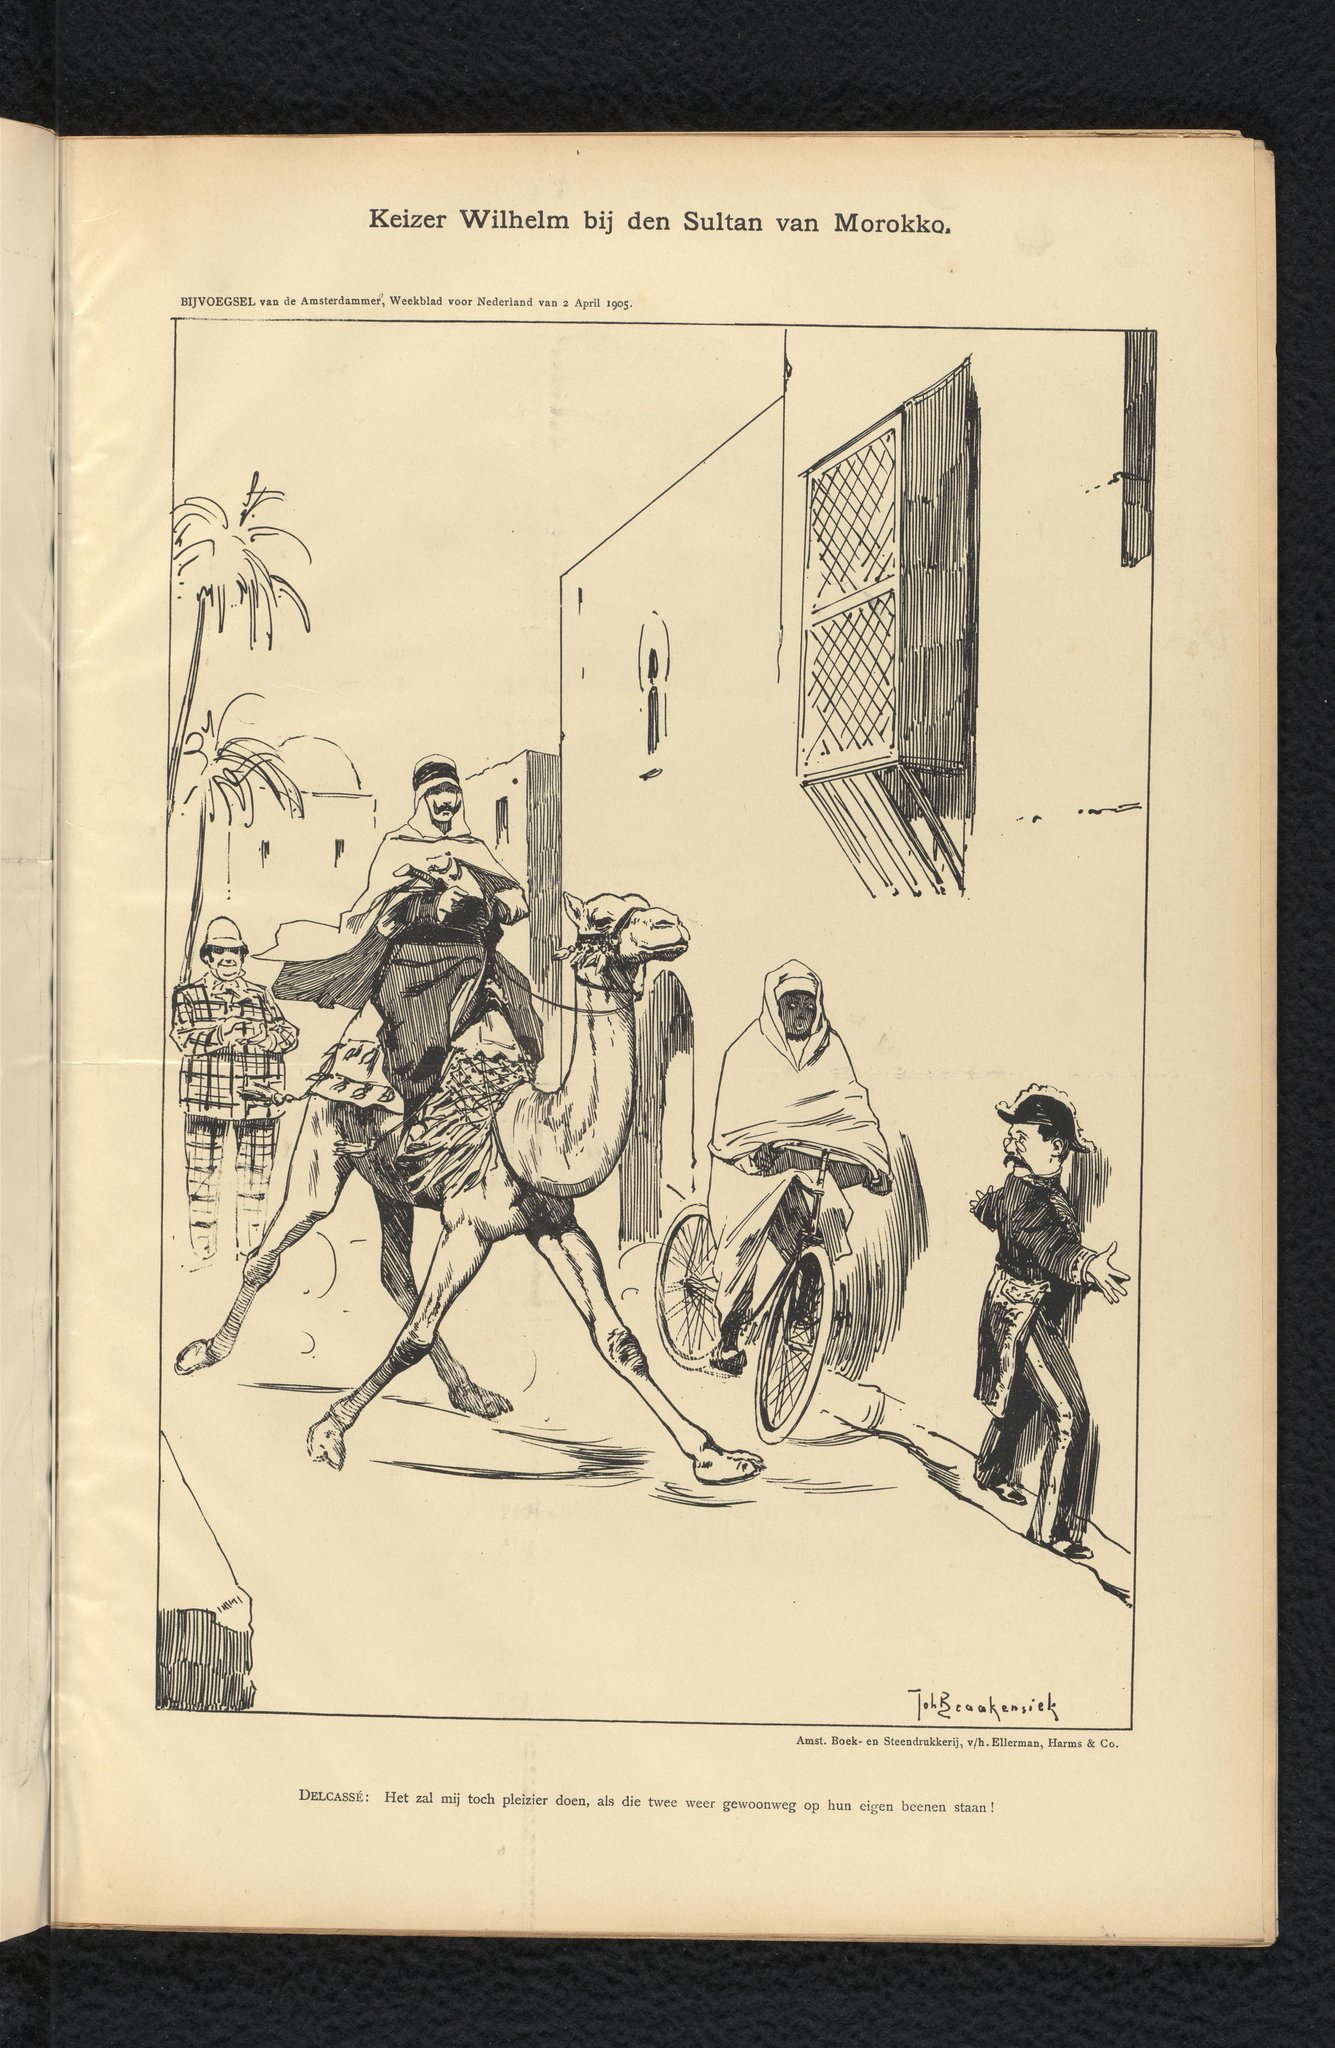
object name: cartoon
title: Keizer Wilhelm bij den Sultan van Morokko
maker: johan braakensiek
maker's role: draughtsman, print maker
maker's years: 1858-1940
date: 1905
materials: paper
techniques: lithograph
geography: amsterdam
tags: wilhelm ii (keizer van duitsland), hoofed animals: dromedary, personifications of countries, nations, states, districts, etc., riding on animal other than horse, ass, or mule, bicycle, political caricatures and satires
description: De Franse minister van Buitenlandse Zaken Delcassé en een Marokkaan op een fiets drukken zich tegen de muur als de Duitse keizer Wilhelm II op een dromedaris door de straten van een Marokkaanse stad komt aangereden. John Bull (Engeland) kijkt lachend toe.